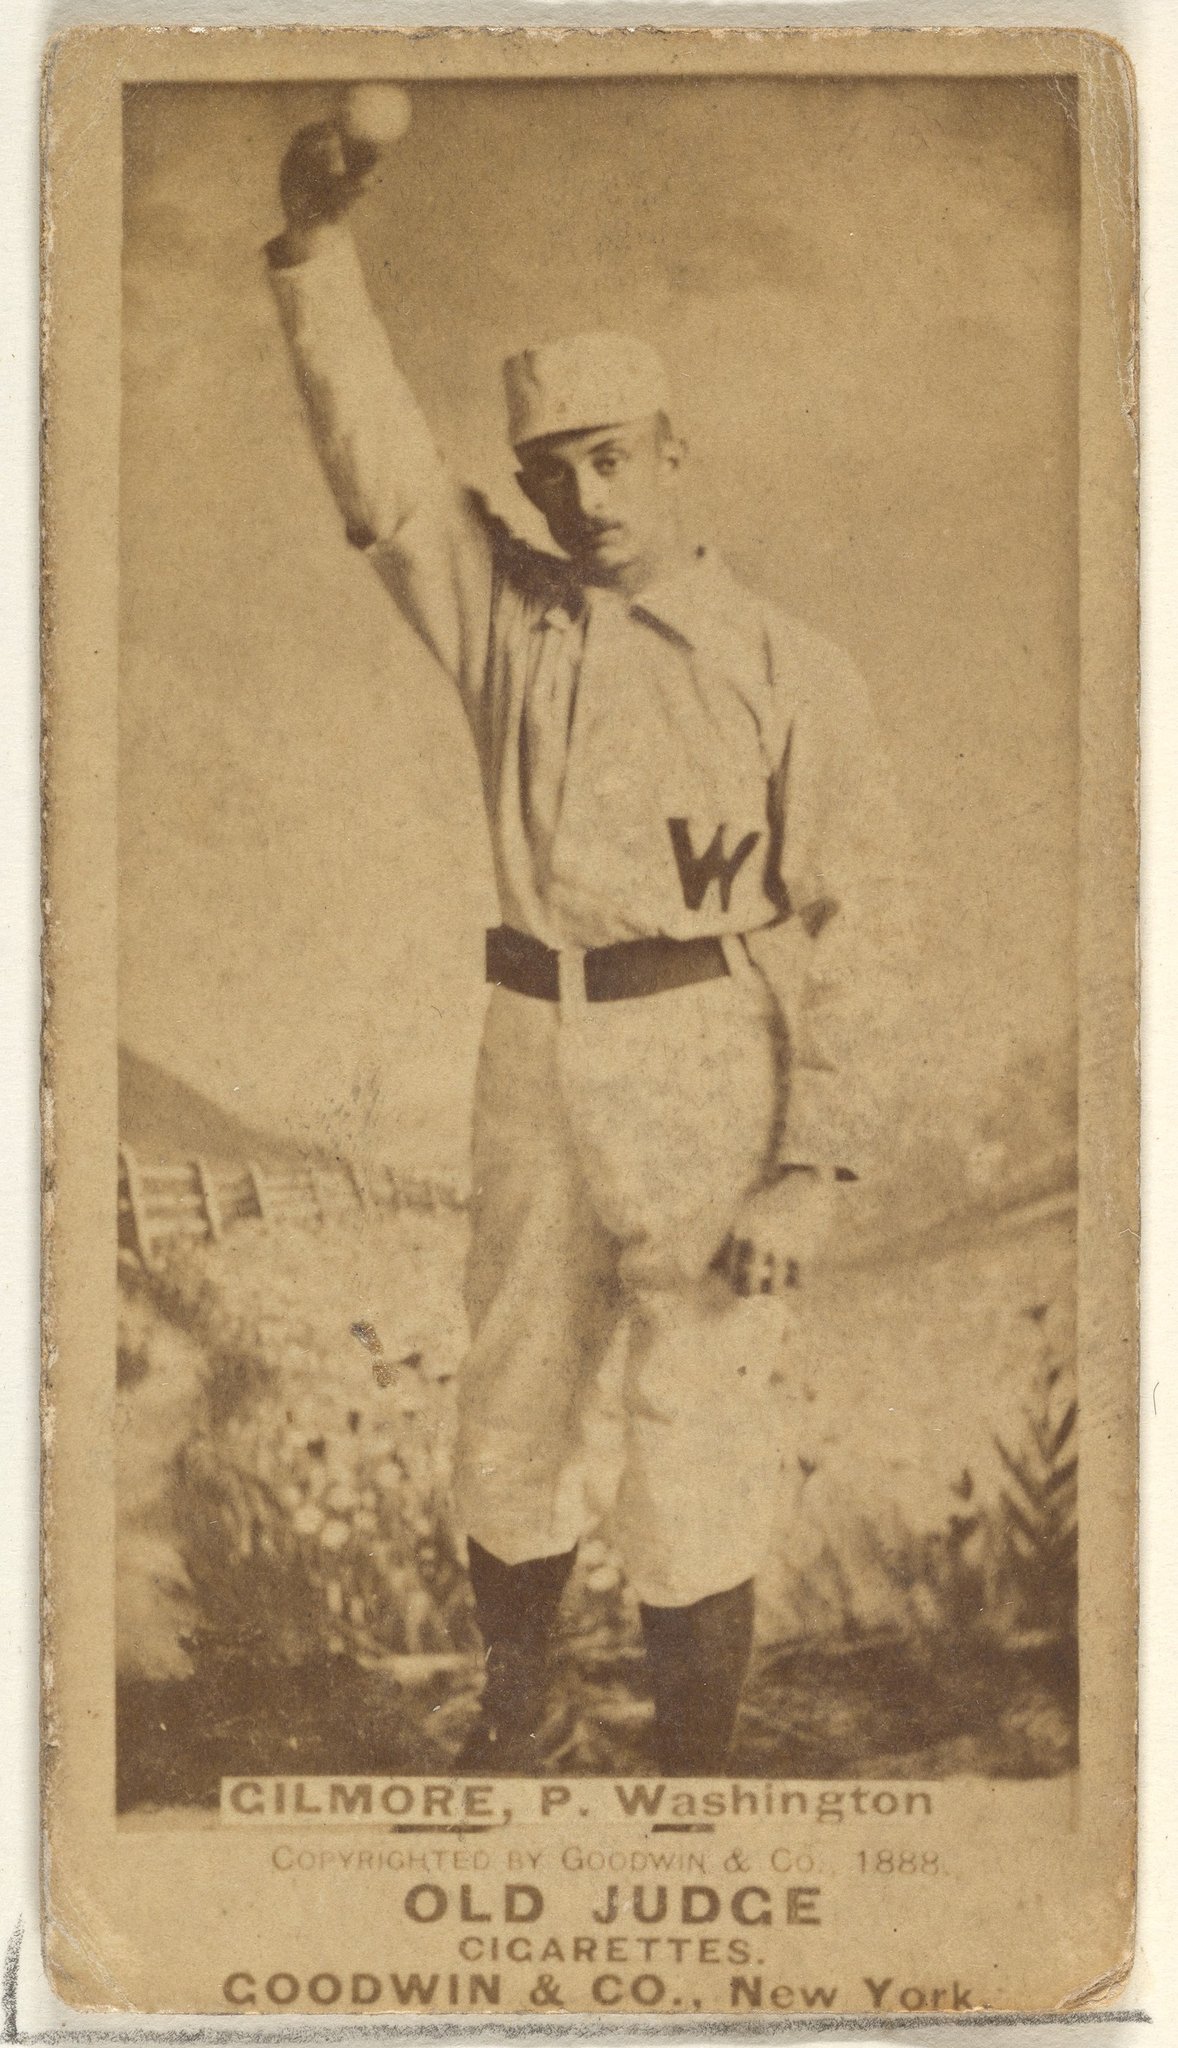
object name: baseball card, photograph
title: Frank T. Gilmore, Pitcher, Washington Nationals, from the Old Judge series (N172) for Old Judge Cigarettes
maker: goodwin & company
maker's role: publisher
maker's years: 1850-1950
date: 1888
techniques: albumen silver print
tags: men,portraits,baseball,athletes